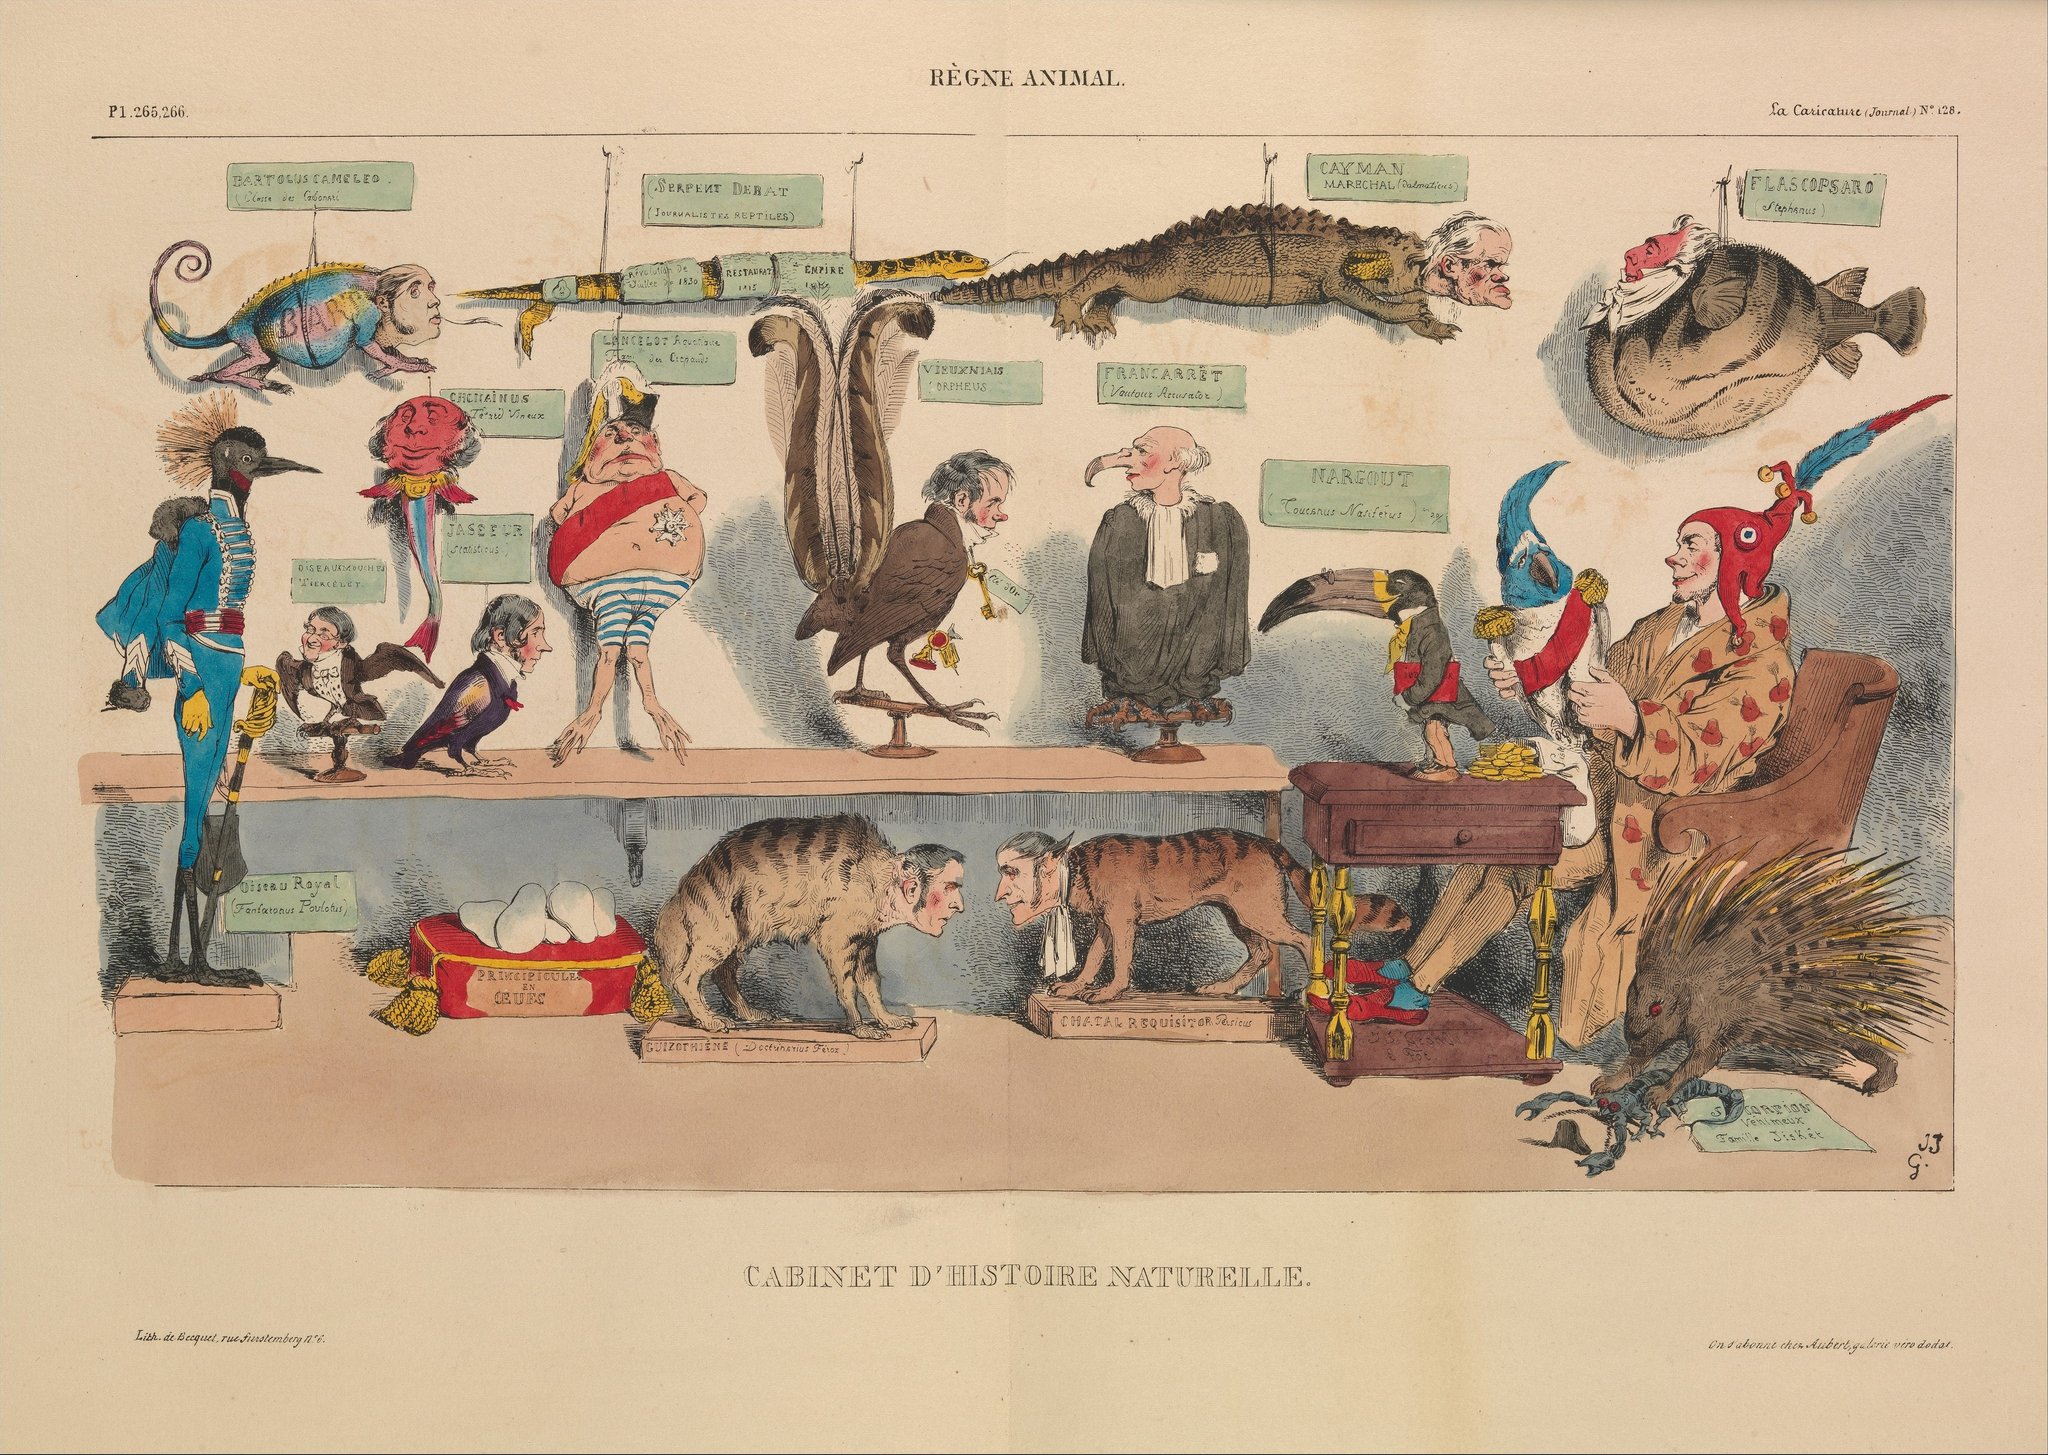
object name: print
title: Animal Kingdom: Natural History Cabinet (Règne animal: Cabinet d'histoire naturelle), from La Caricature, plates 265 and 266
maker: j. j. grandville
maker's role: artist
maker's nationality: french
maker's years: 1803-1847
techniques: hand coloring, lithograph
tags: satire